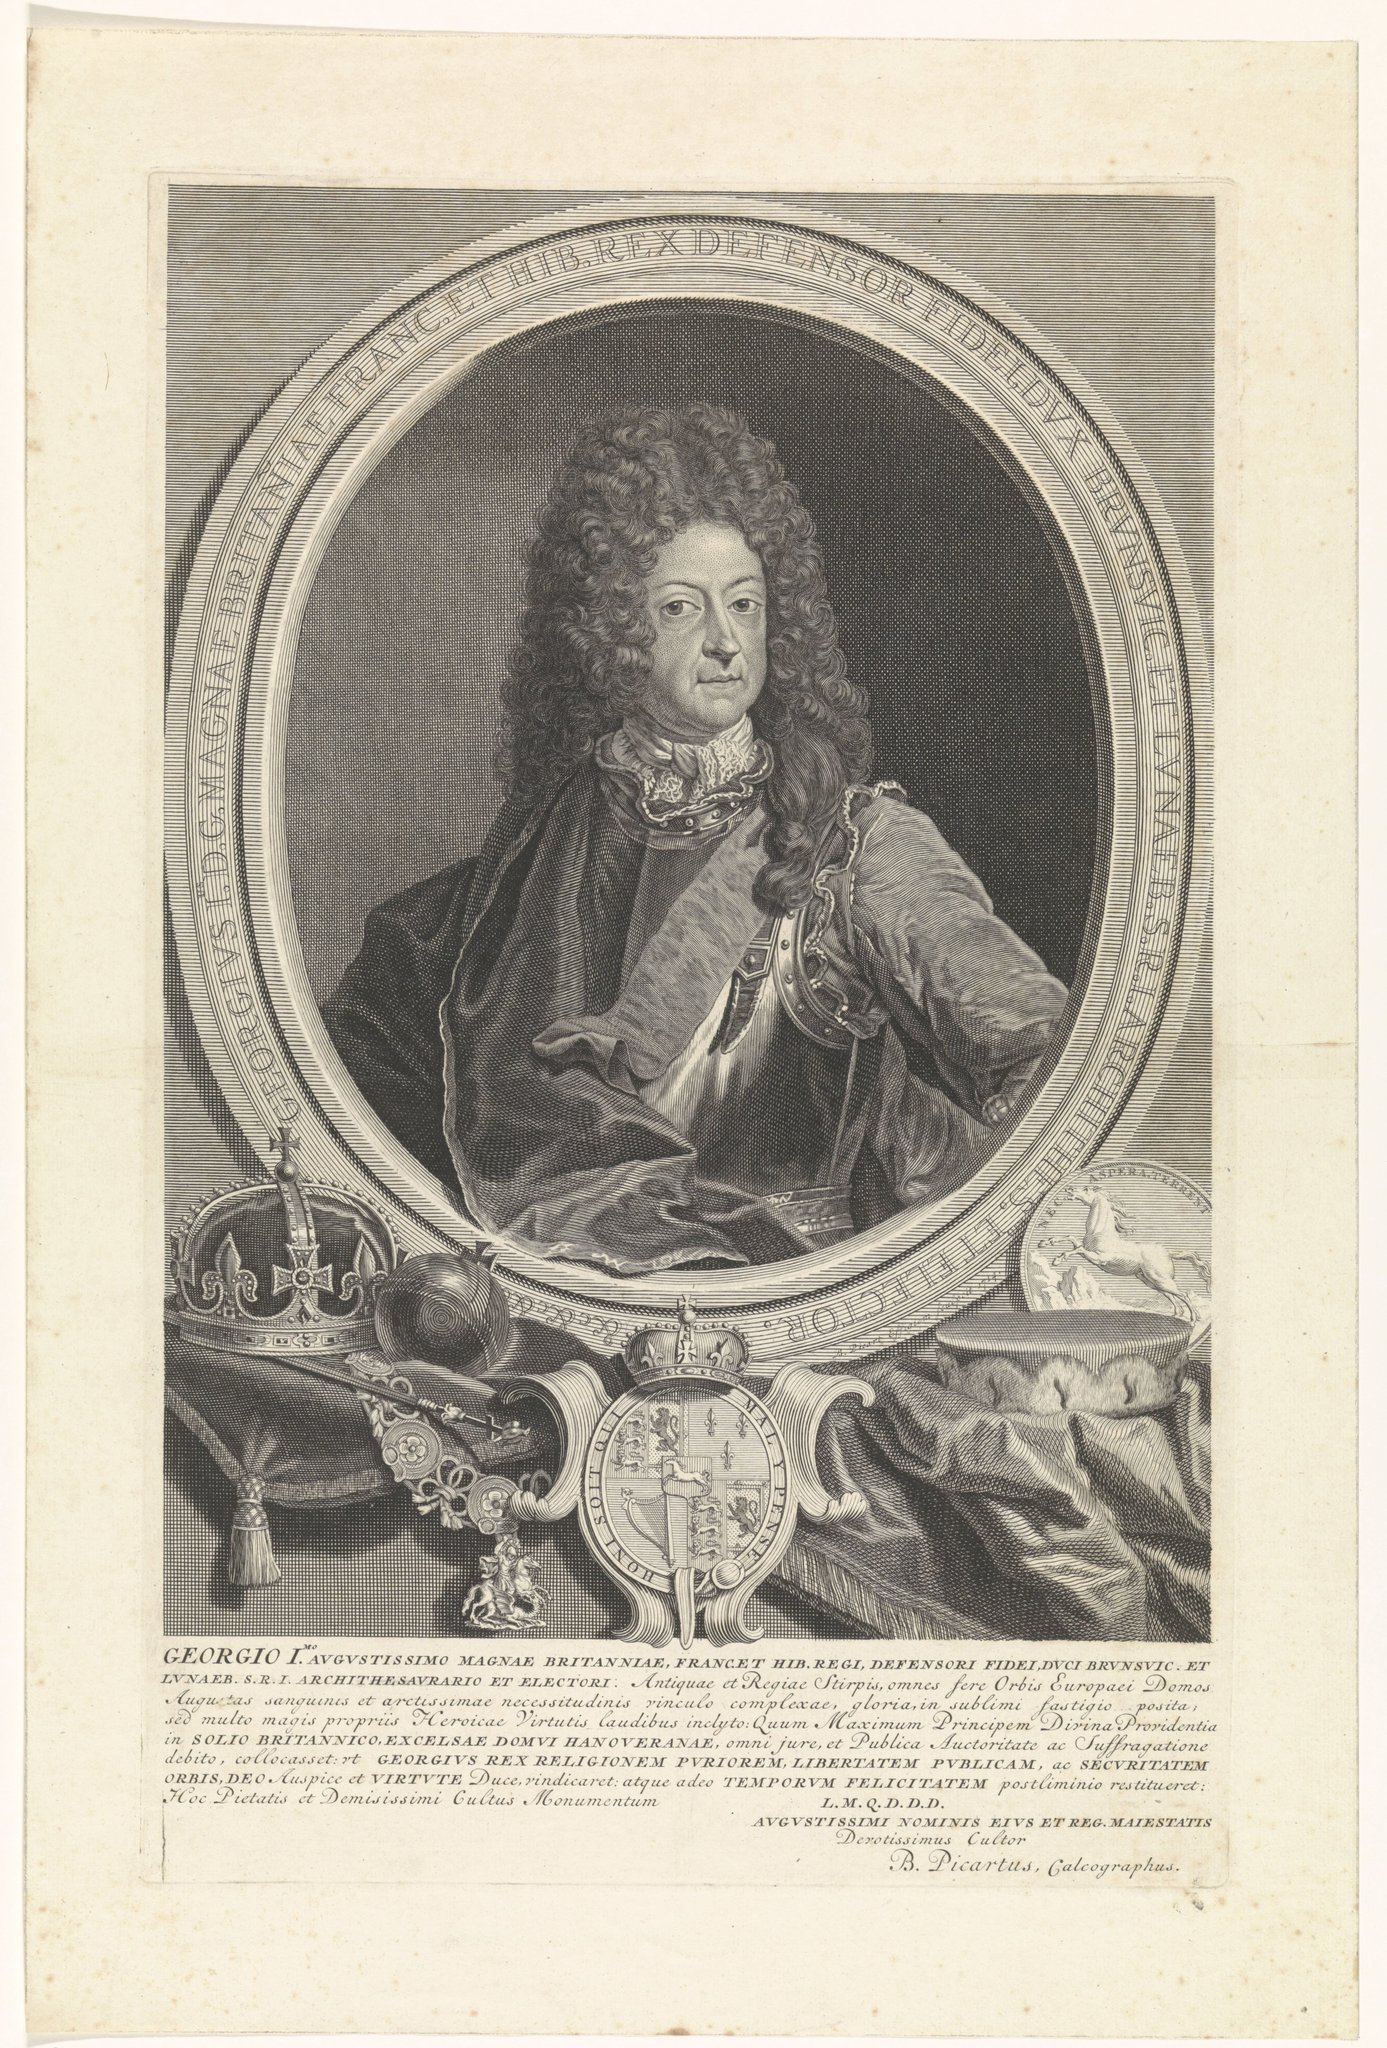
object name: print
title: Portret van George I van Engeland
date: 1714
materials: paper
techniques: engraving, etching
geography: amsterdam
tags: george i (koning van groot-brittannië en ierland), coat of arms (symbol of sovereignty), crown (symbol of sovereignty), knighthood order, armour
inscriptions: collector's mark: Lugt 240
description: Portret van George I, koning van Engeland en Ierland. Onder de omlijsting zijn wapenschild met zijn devies in het Latijn. Op een draperie een kroon, een rijksappel, een keten met de Constantijnse Orde van Sint Joris en een medaillon waarop een paard. In de marge een achtregelig onderschrift in het Latijn.